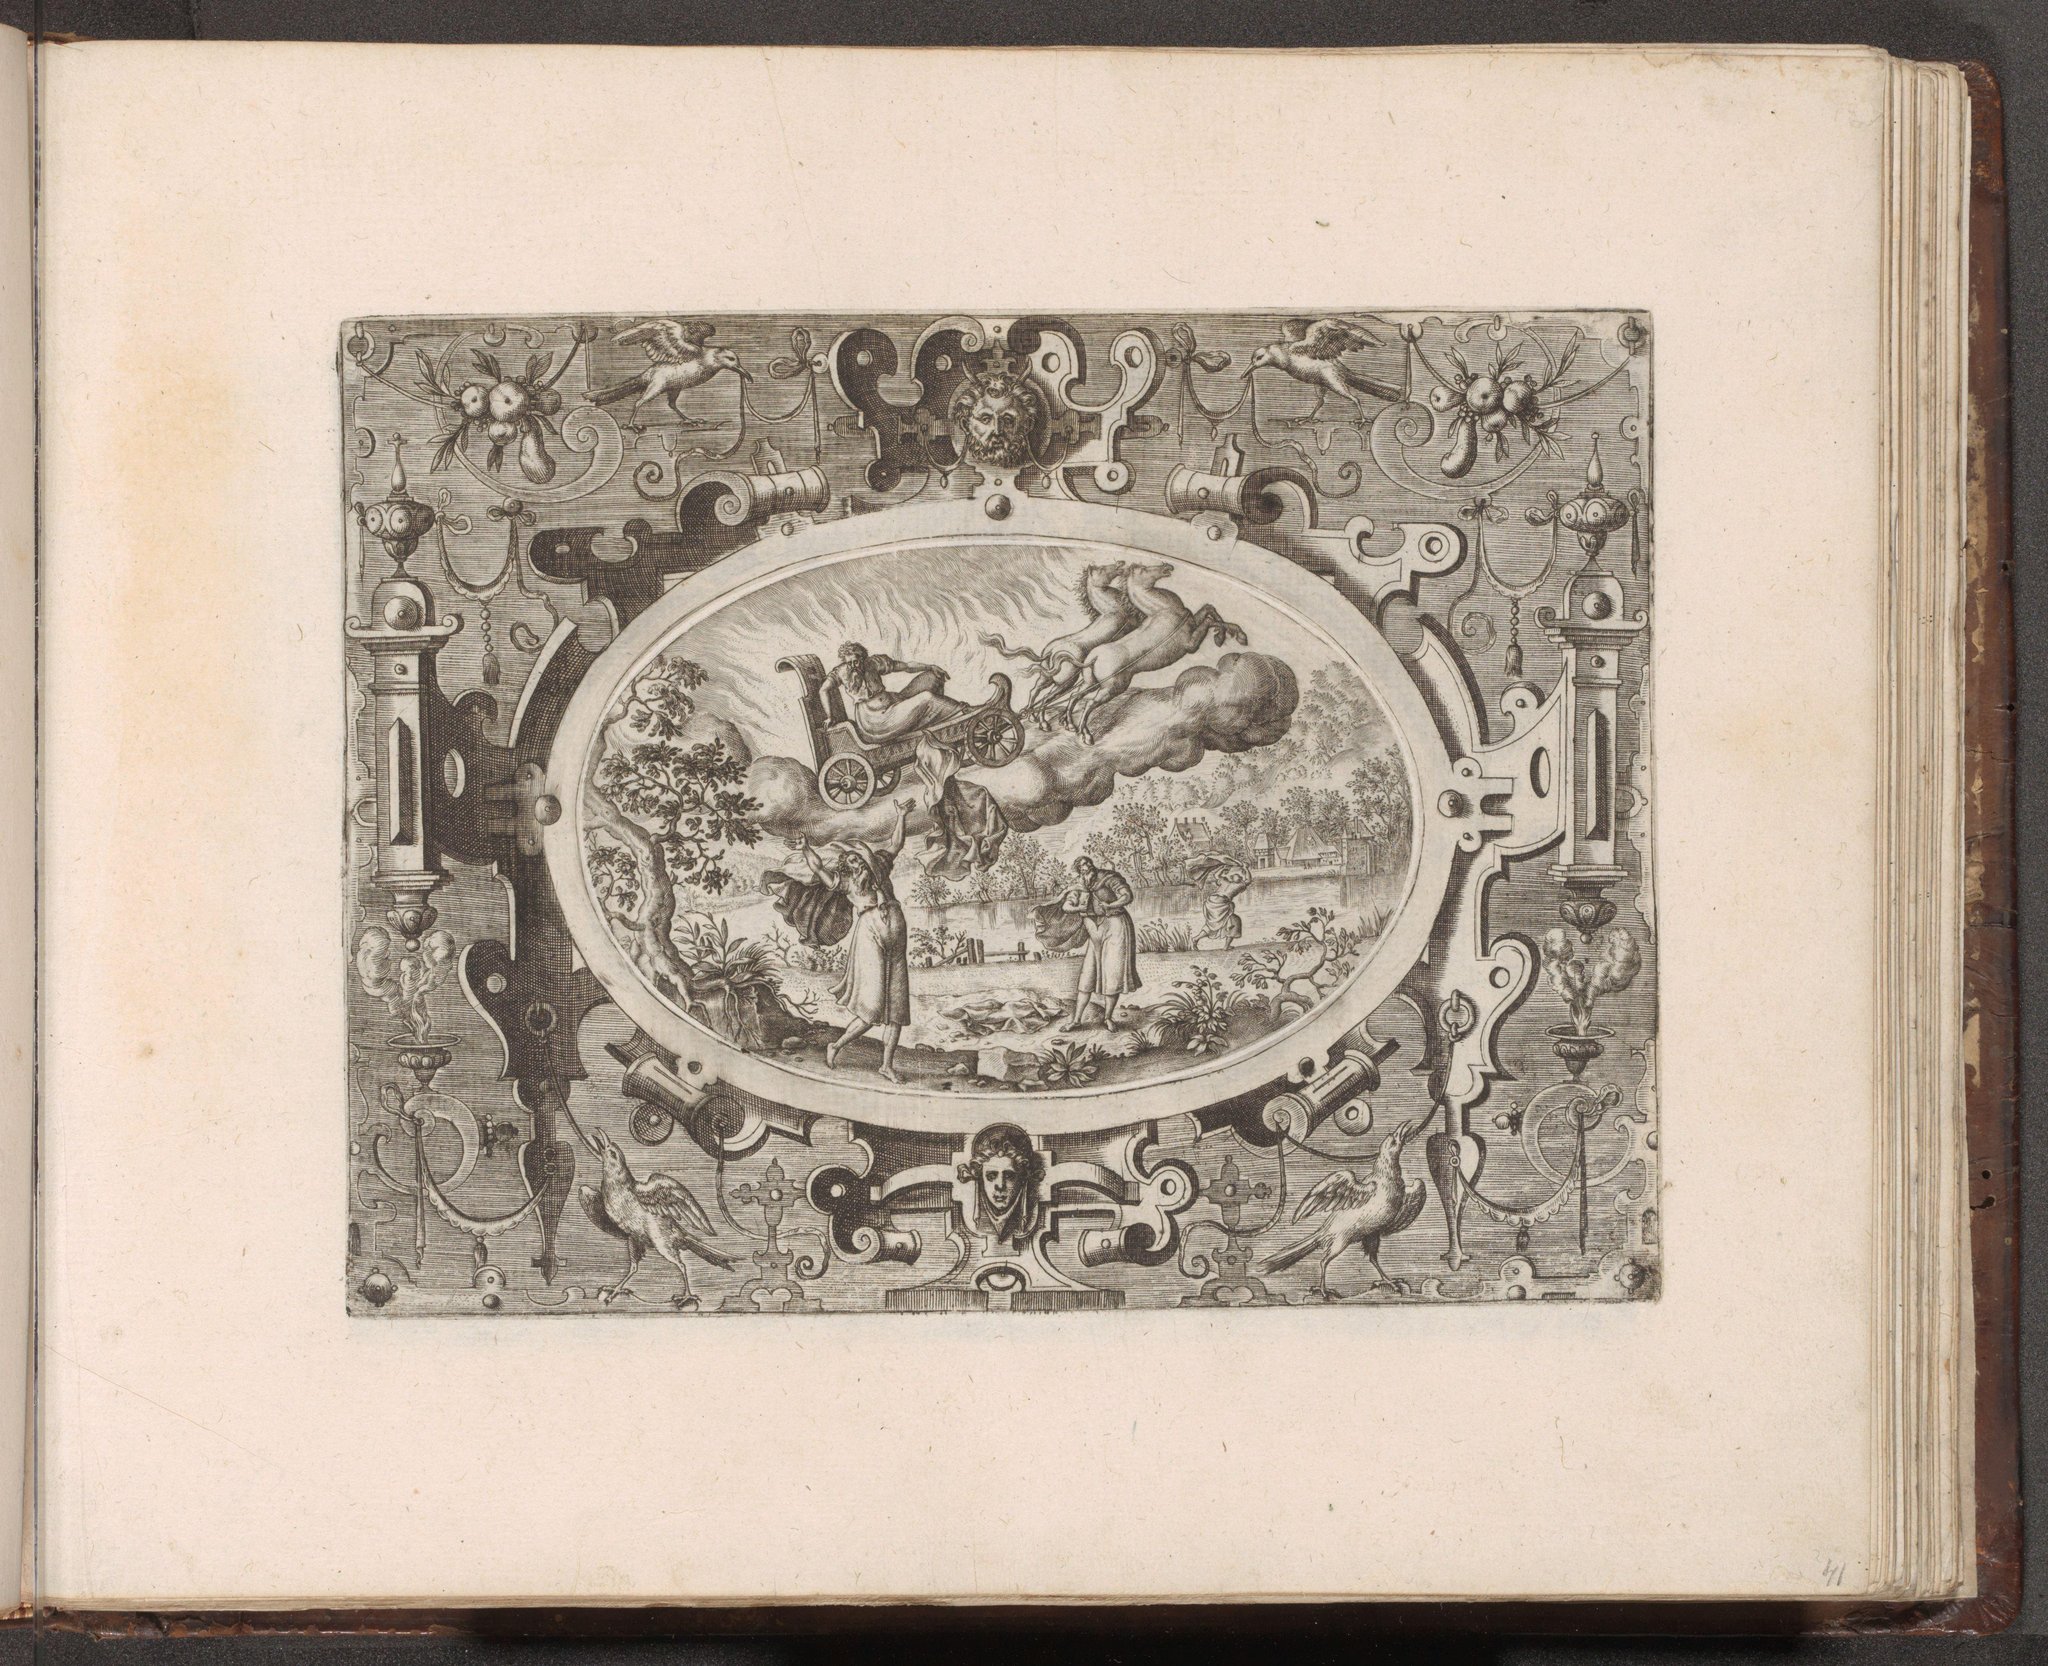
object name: album leaf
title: Thesaurus sacrarum historiaru[m] veteris testame[n]ti, elega[n]tissimis imaginibus expressu[m] excelle[n]tissimoru[m] in hac arte viroru[m] opera: nu[n]c primu[m] in luce[m] editus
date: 1579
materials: paper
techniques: engraving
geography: antwerp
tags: elisha strikes the water with elijah's cloak, parts the water and recrosses the river; he thus wins recognition from the sons of the prophets, frequently used ornamental compositions, a chariot, horses of fire and a whirlwind appear and elijah is carried up into heaven; elijah's cloak falls (or he hands it over to elisha)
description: De profeet Elisa ziet hoe Elia in een vurige wagen naar de hemel rijdt. De mantel van Elia valt naar beneden. Op de achtergrond scheurt Elisa zijn kleren als hij Elia niet meer kan zien. De mantel van Elia ligt naast hem. Nog verder op de achtergrond slaat Elisa het water van de Jordaan met de mantel van Elia, zodat het naar links en rechts stroomt en hij de rivier kan oversteken. Ovale voorstelling in een ormanetele omlijsting. Prent maakt deel uit van een album.